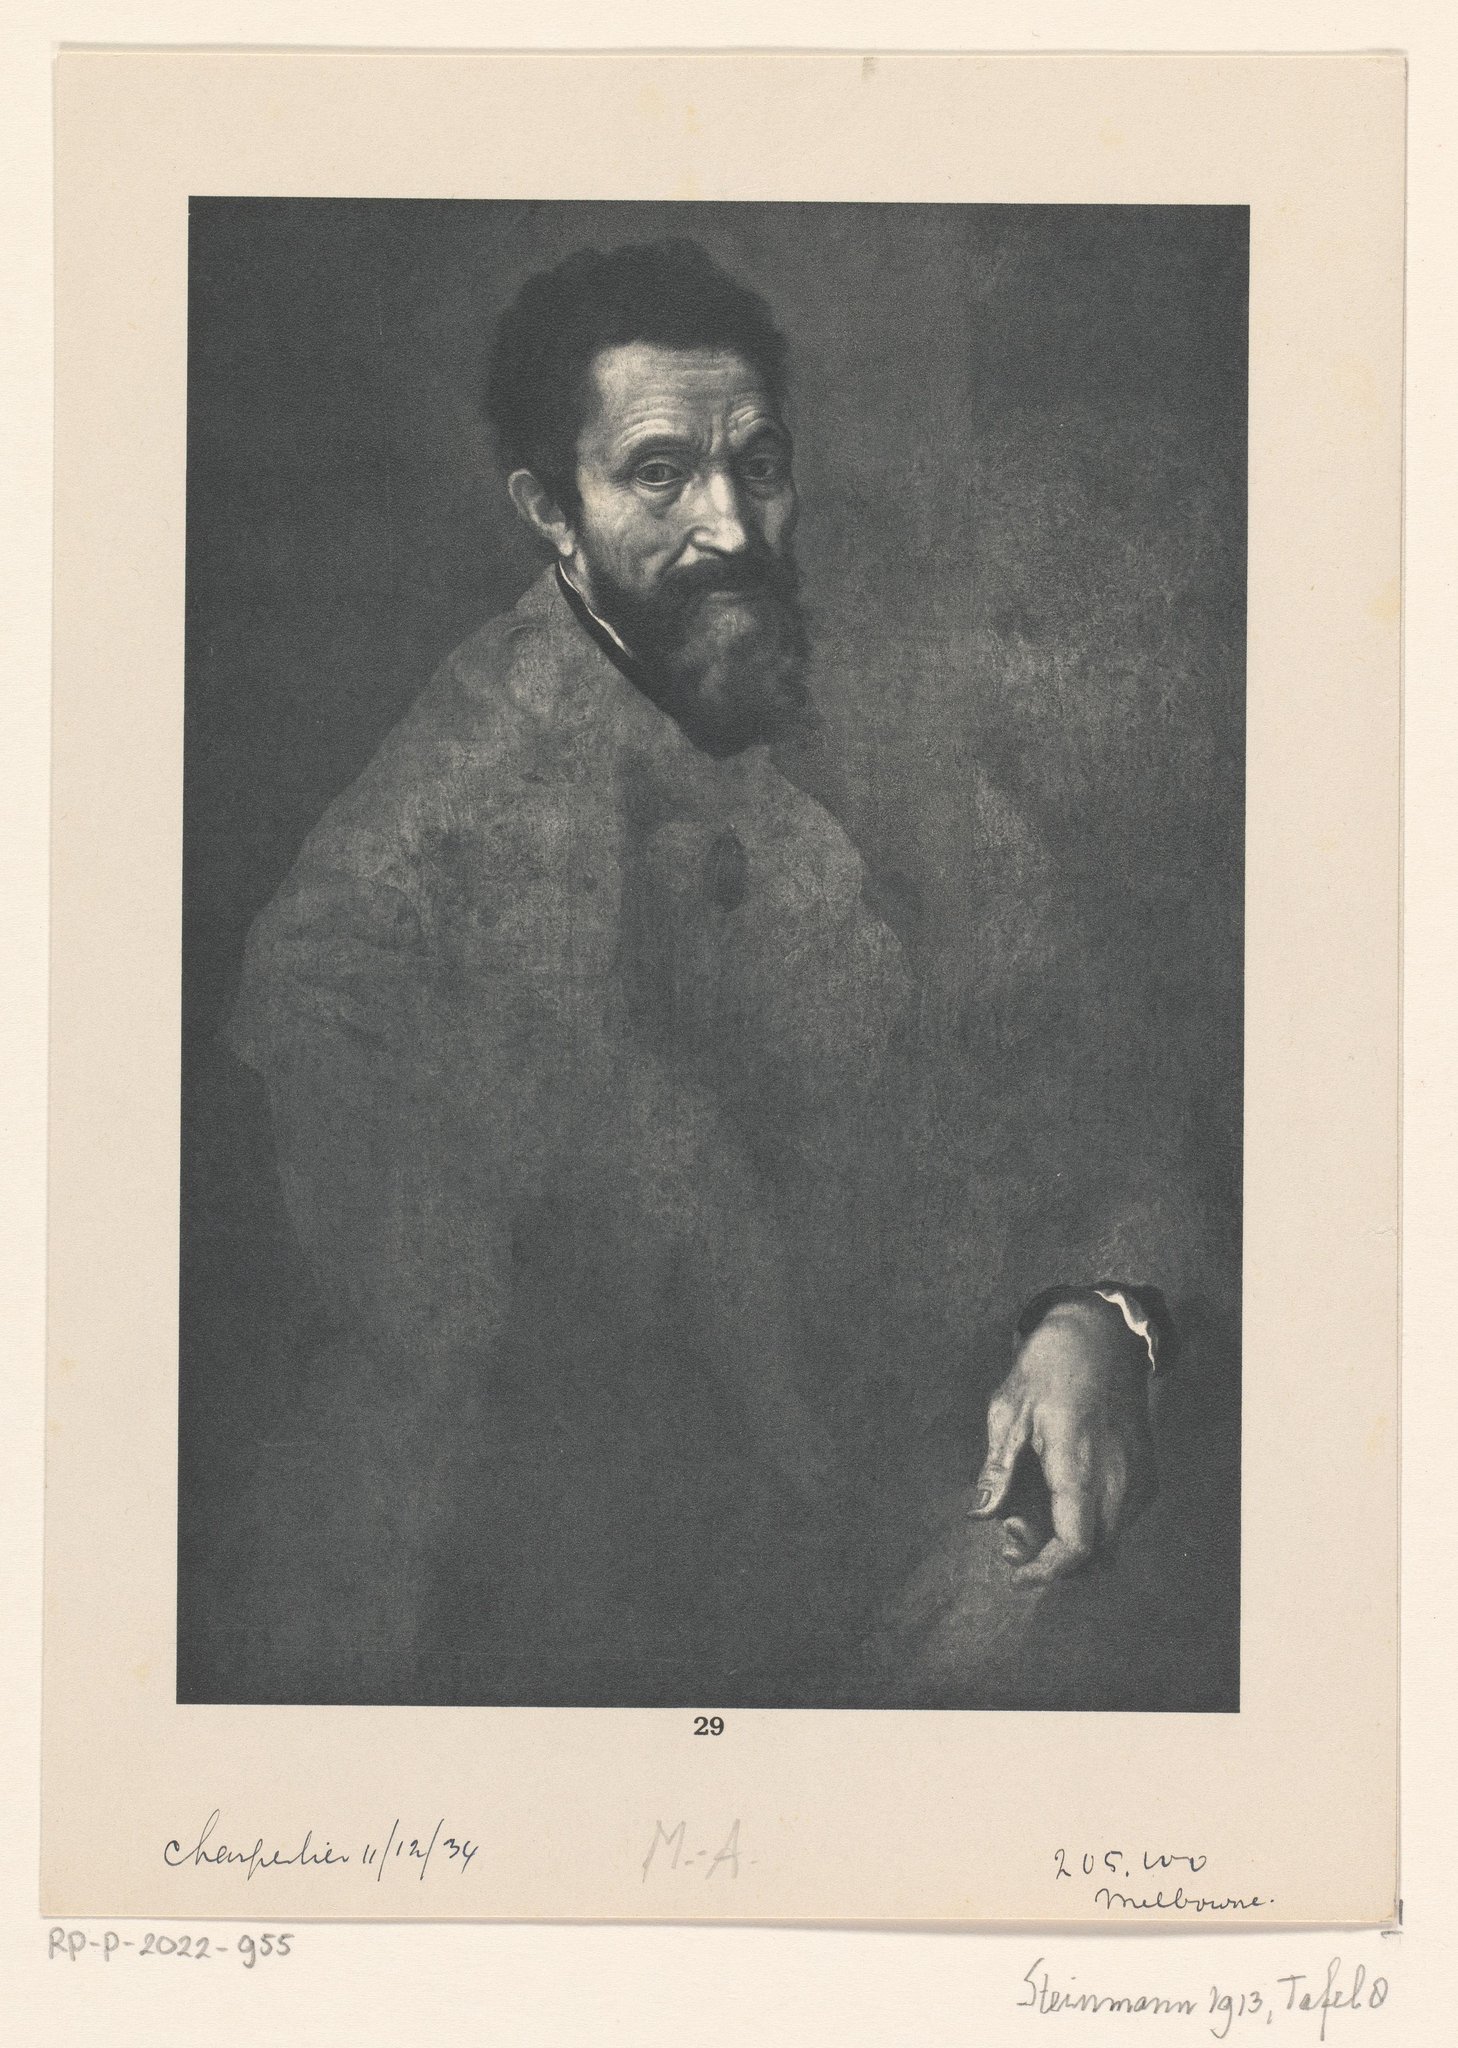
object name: photomechanical print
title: Portret van Michelangelo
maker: Anonymous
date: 1934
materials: paper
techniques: photograph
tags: draughtsman, sculptor, michelangelo, historical persons, portrait, self-portrait of artist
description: Schilderij verkocht op een veiling in Galerie Jean Charpentier, Parijs op 11 december 1934 aan Sidney Weiller. Afdruk waarschijnlijk uit de bijbehorende catalogus.